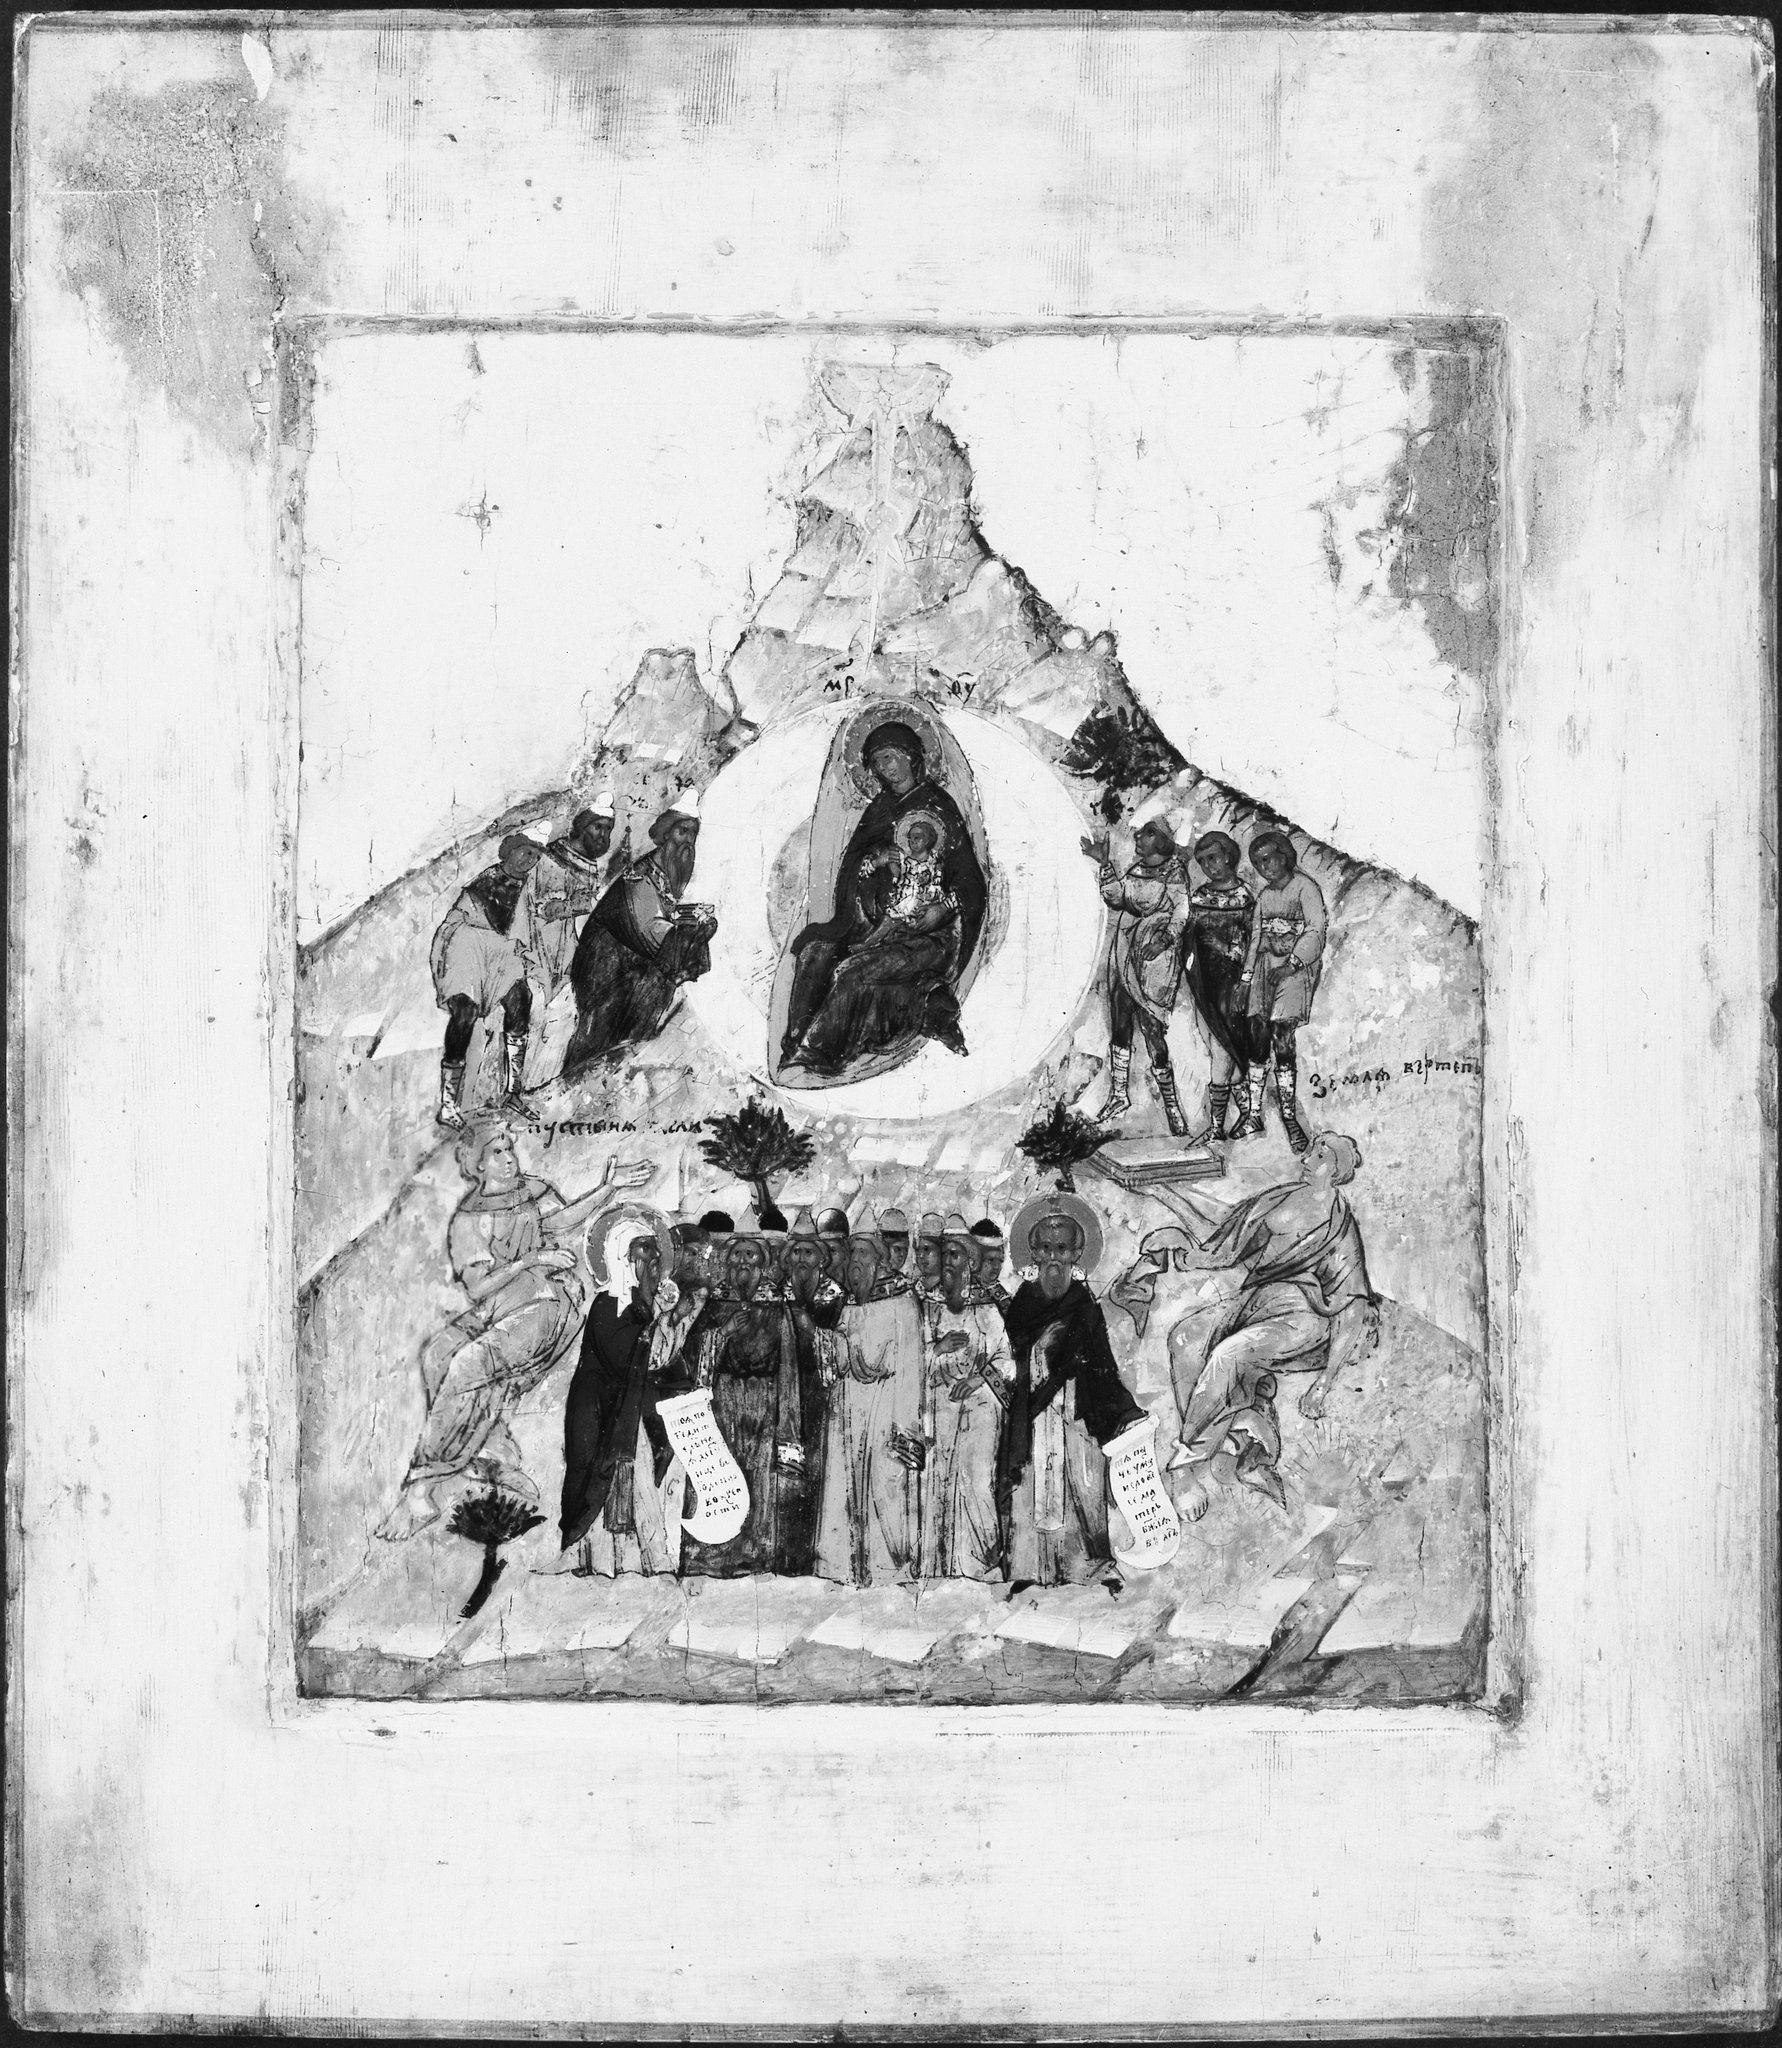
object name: painting, icon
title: The Congregation of the Mother of God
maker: russian painter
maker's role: artist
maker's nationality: russian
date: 1570-1629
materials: paint, wood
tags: men,christ,virgin mary,saints